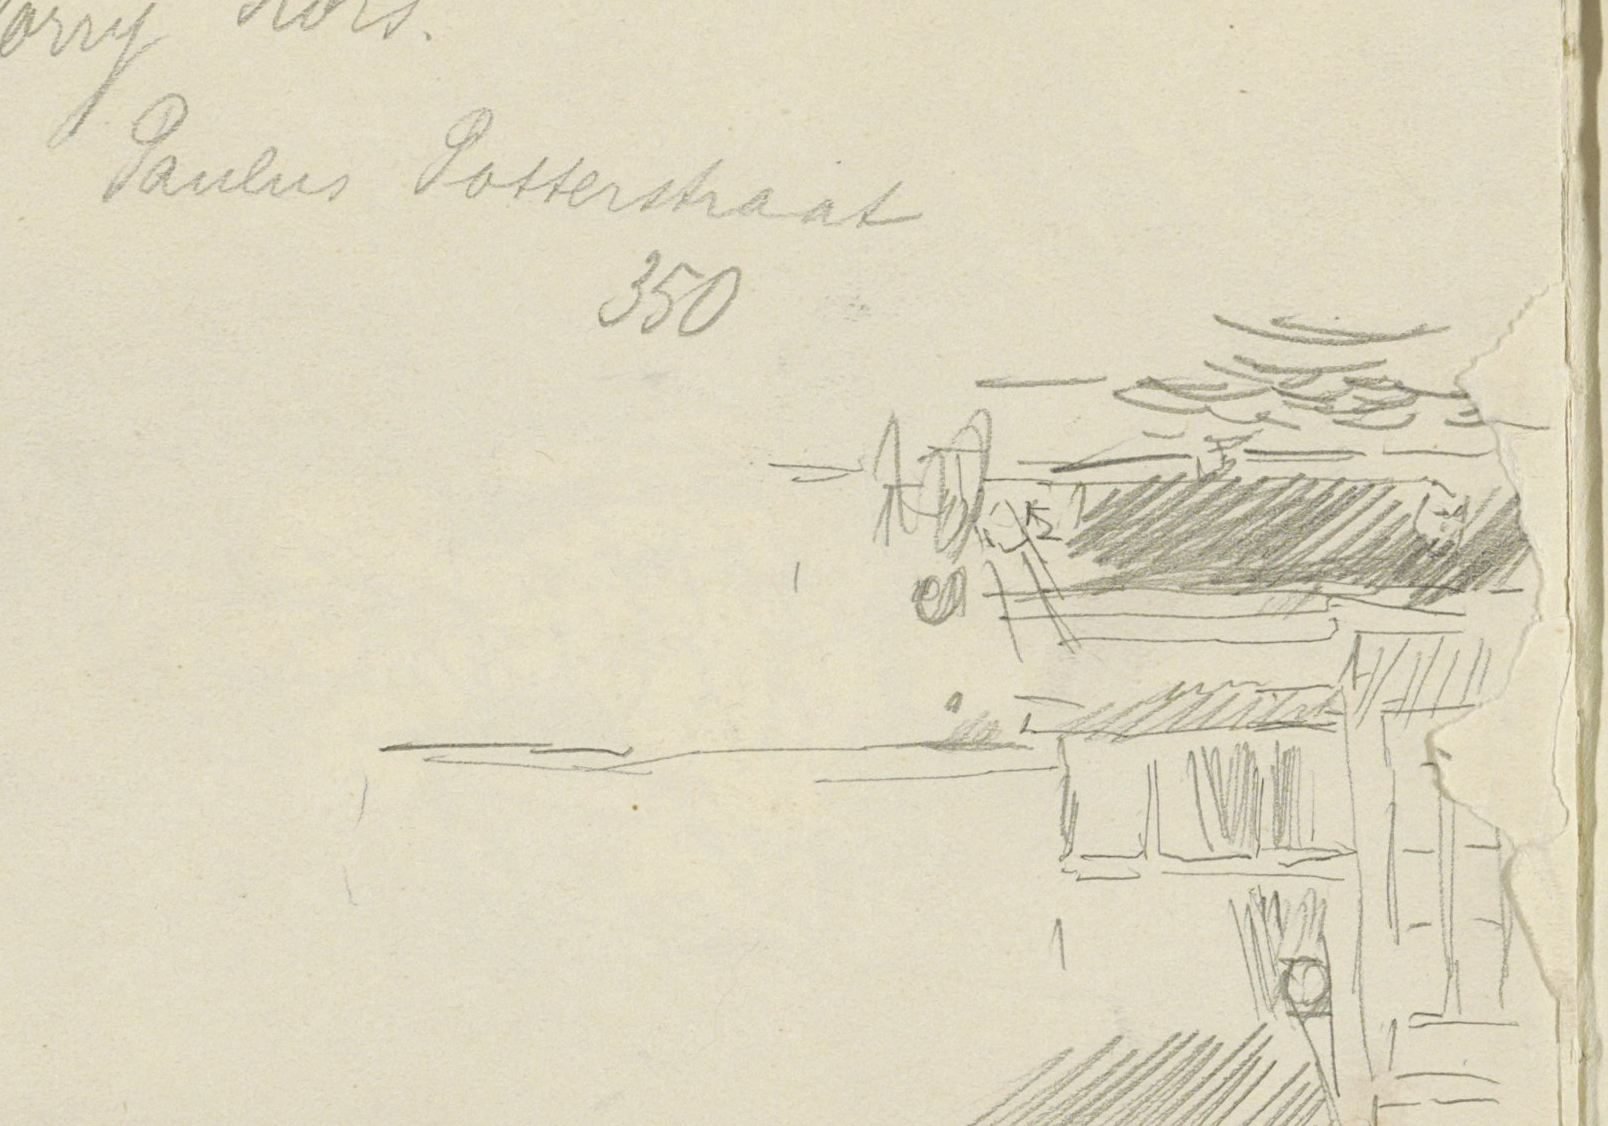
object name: sketchbook leaf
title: Straatgezicht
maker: isaac israels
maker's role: draughtsman, painter, print maker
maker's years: 1865-1934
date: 1930-1934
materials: paper, pencil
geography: the hague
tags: street (+ city(-scape) with figures, staffage)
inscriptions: annotation: ‘Corry Kors / Paulus Potterstraat / 350’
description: Pagina 45 uit schetsboek XXXVIII met 45 pagina's.